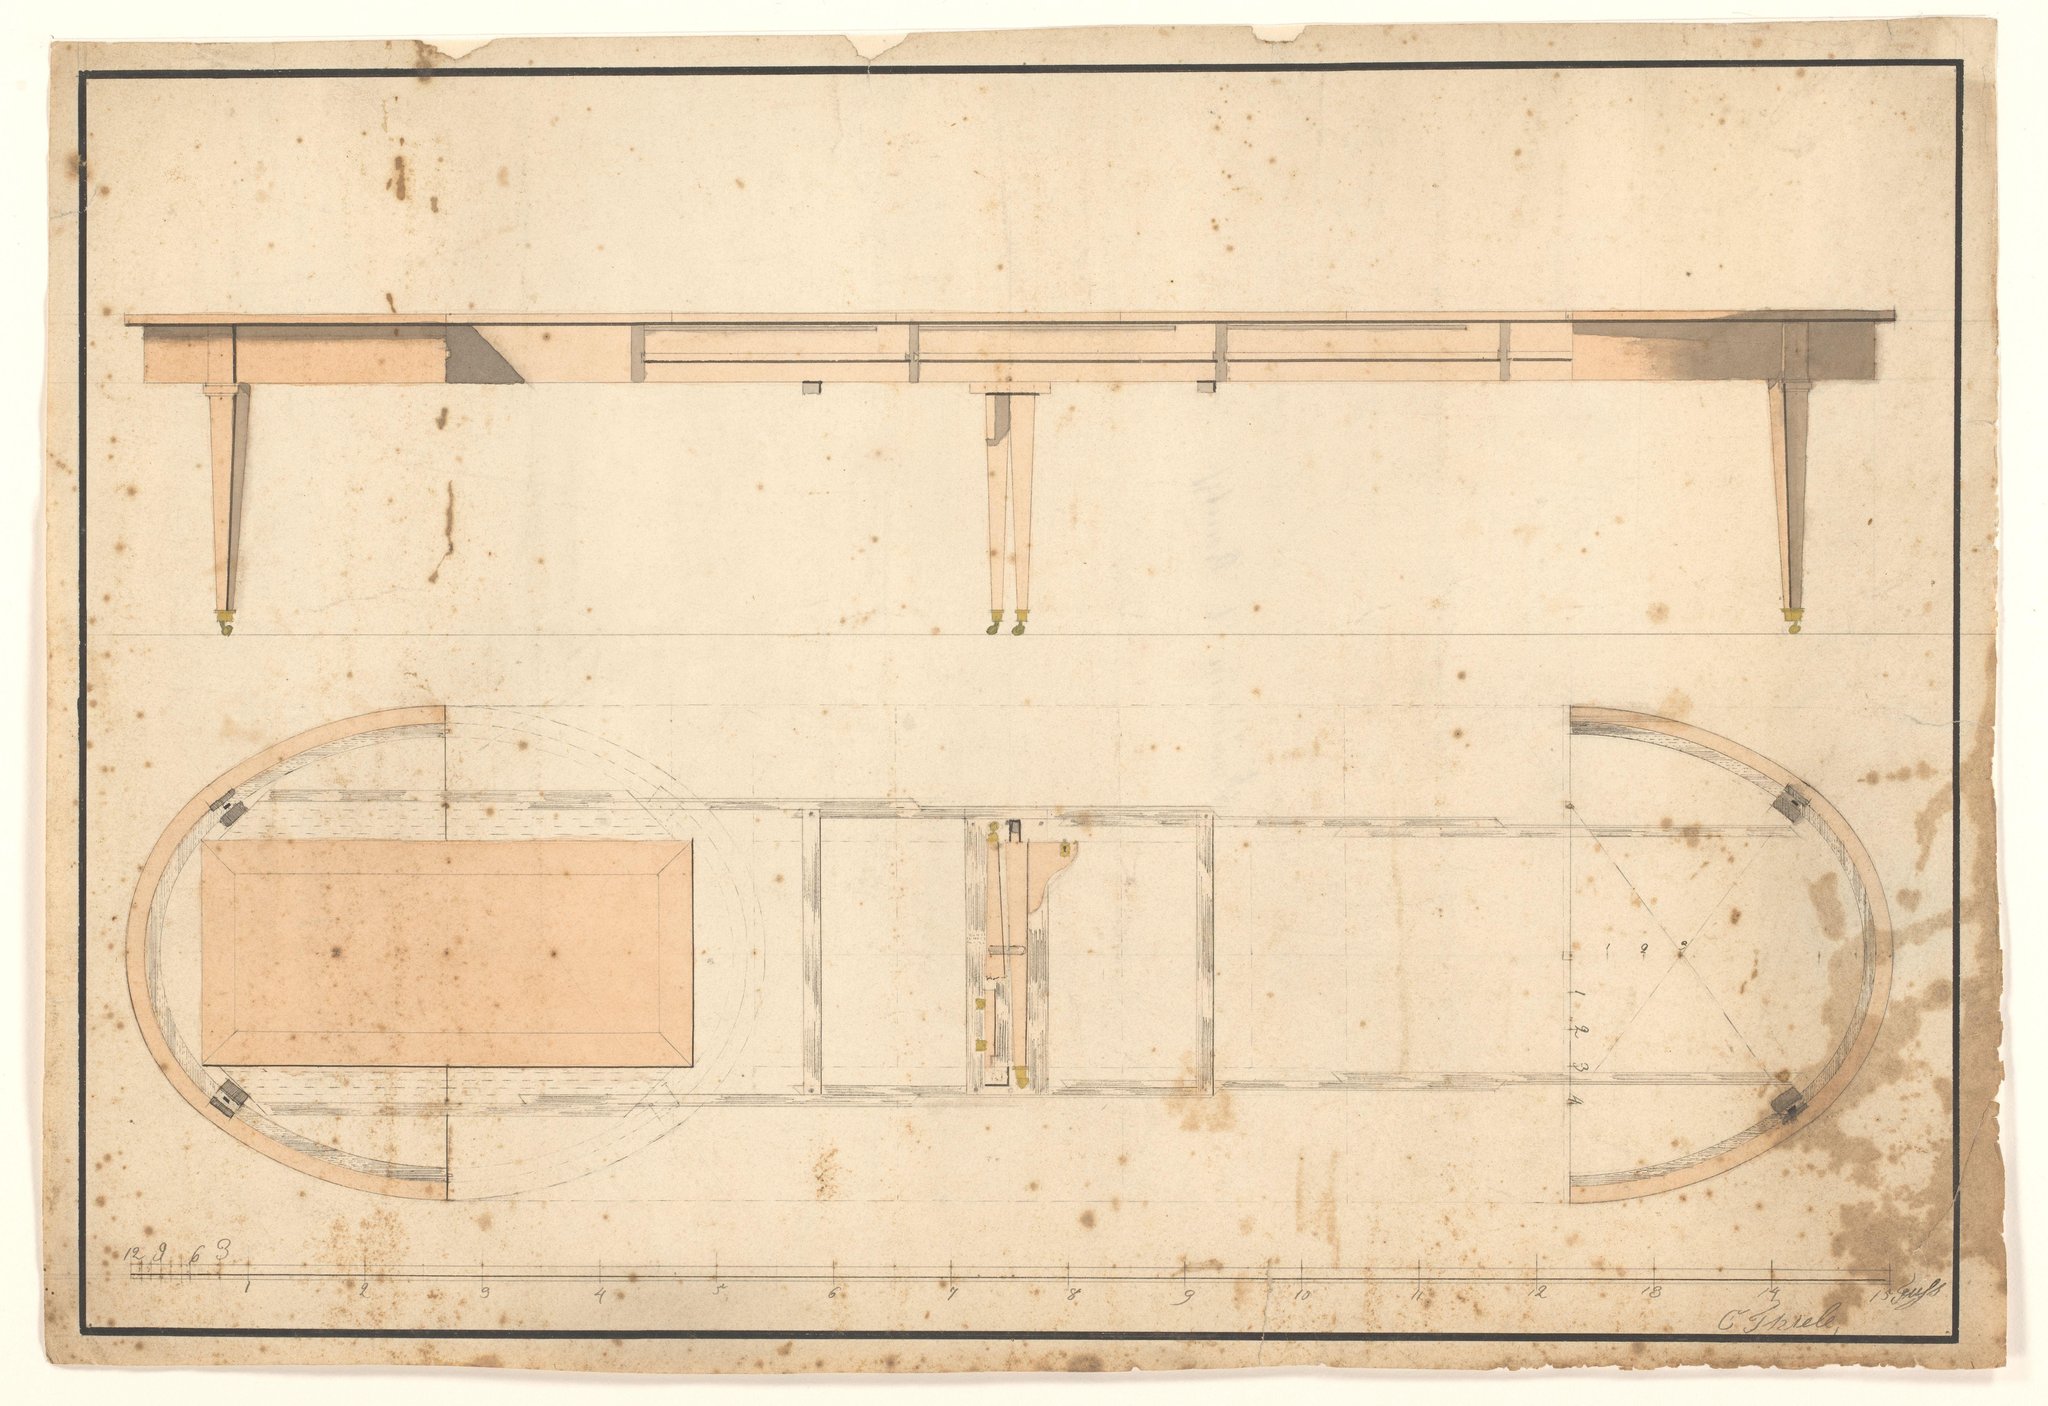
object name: design drawing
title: Ontwerp voor een uittrektafel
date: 1820-1830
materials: ink, paper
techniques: brush, pen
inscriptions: name: ‘Fräulein L R Kautzsch’, signature: ‘C Thiele’, inscription: ‘12 9 6 3 1 2 3 4 5 6 7 8 9 10 11 12 13 14 15 Fuss’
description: Zijaanzicht met daaronder een plattegrond, daaronder een maatverdeling.